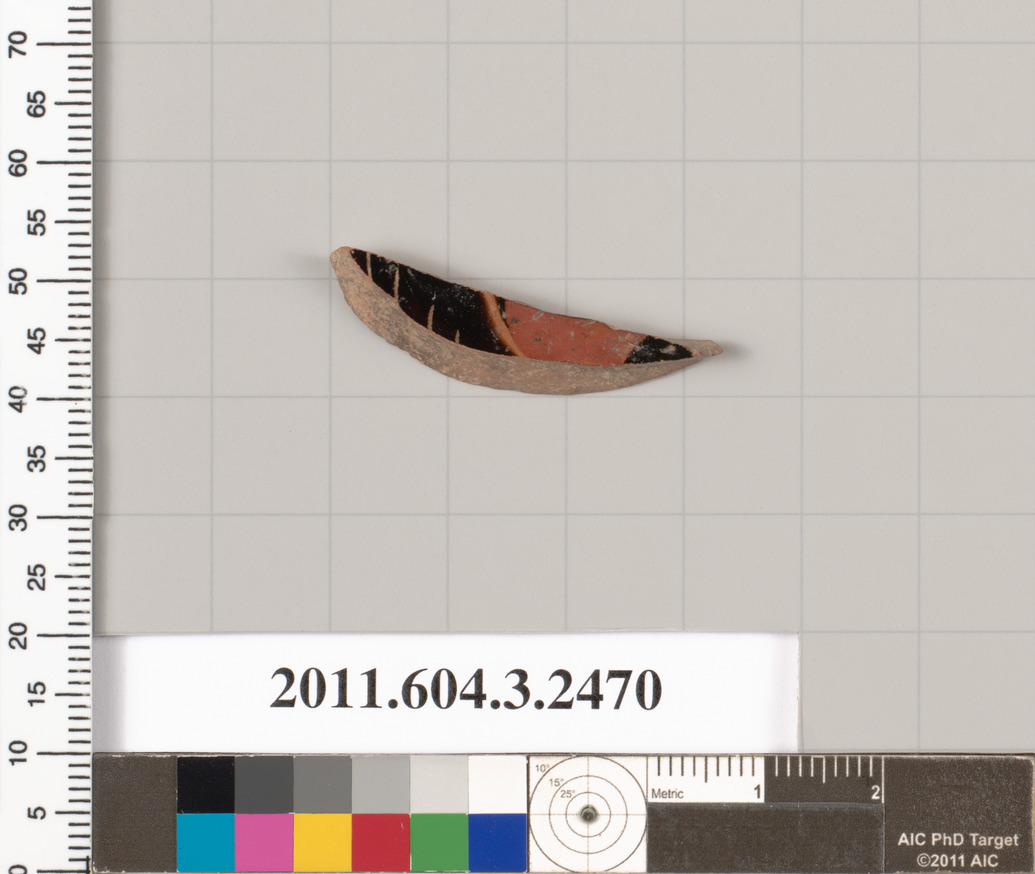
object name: kylix fragment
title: Terracotta fragment of a kylix: eye-cup (drinking cup)?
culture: greek, attic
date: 525-501 BCE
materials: terracotta